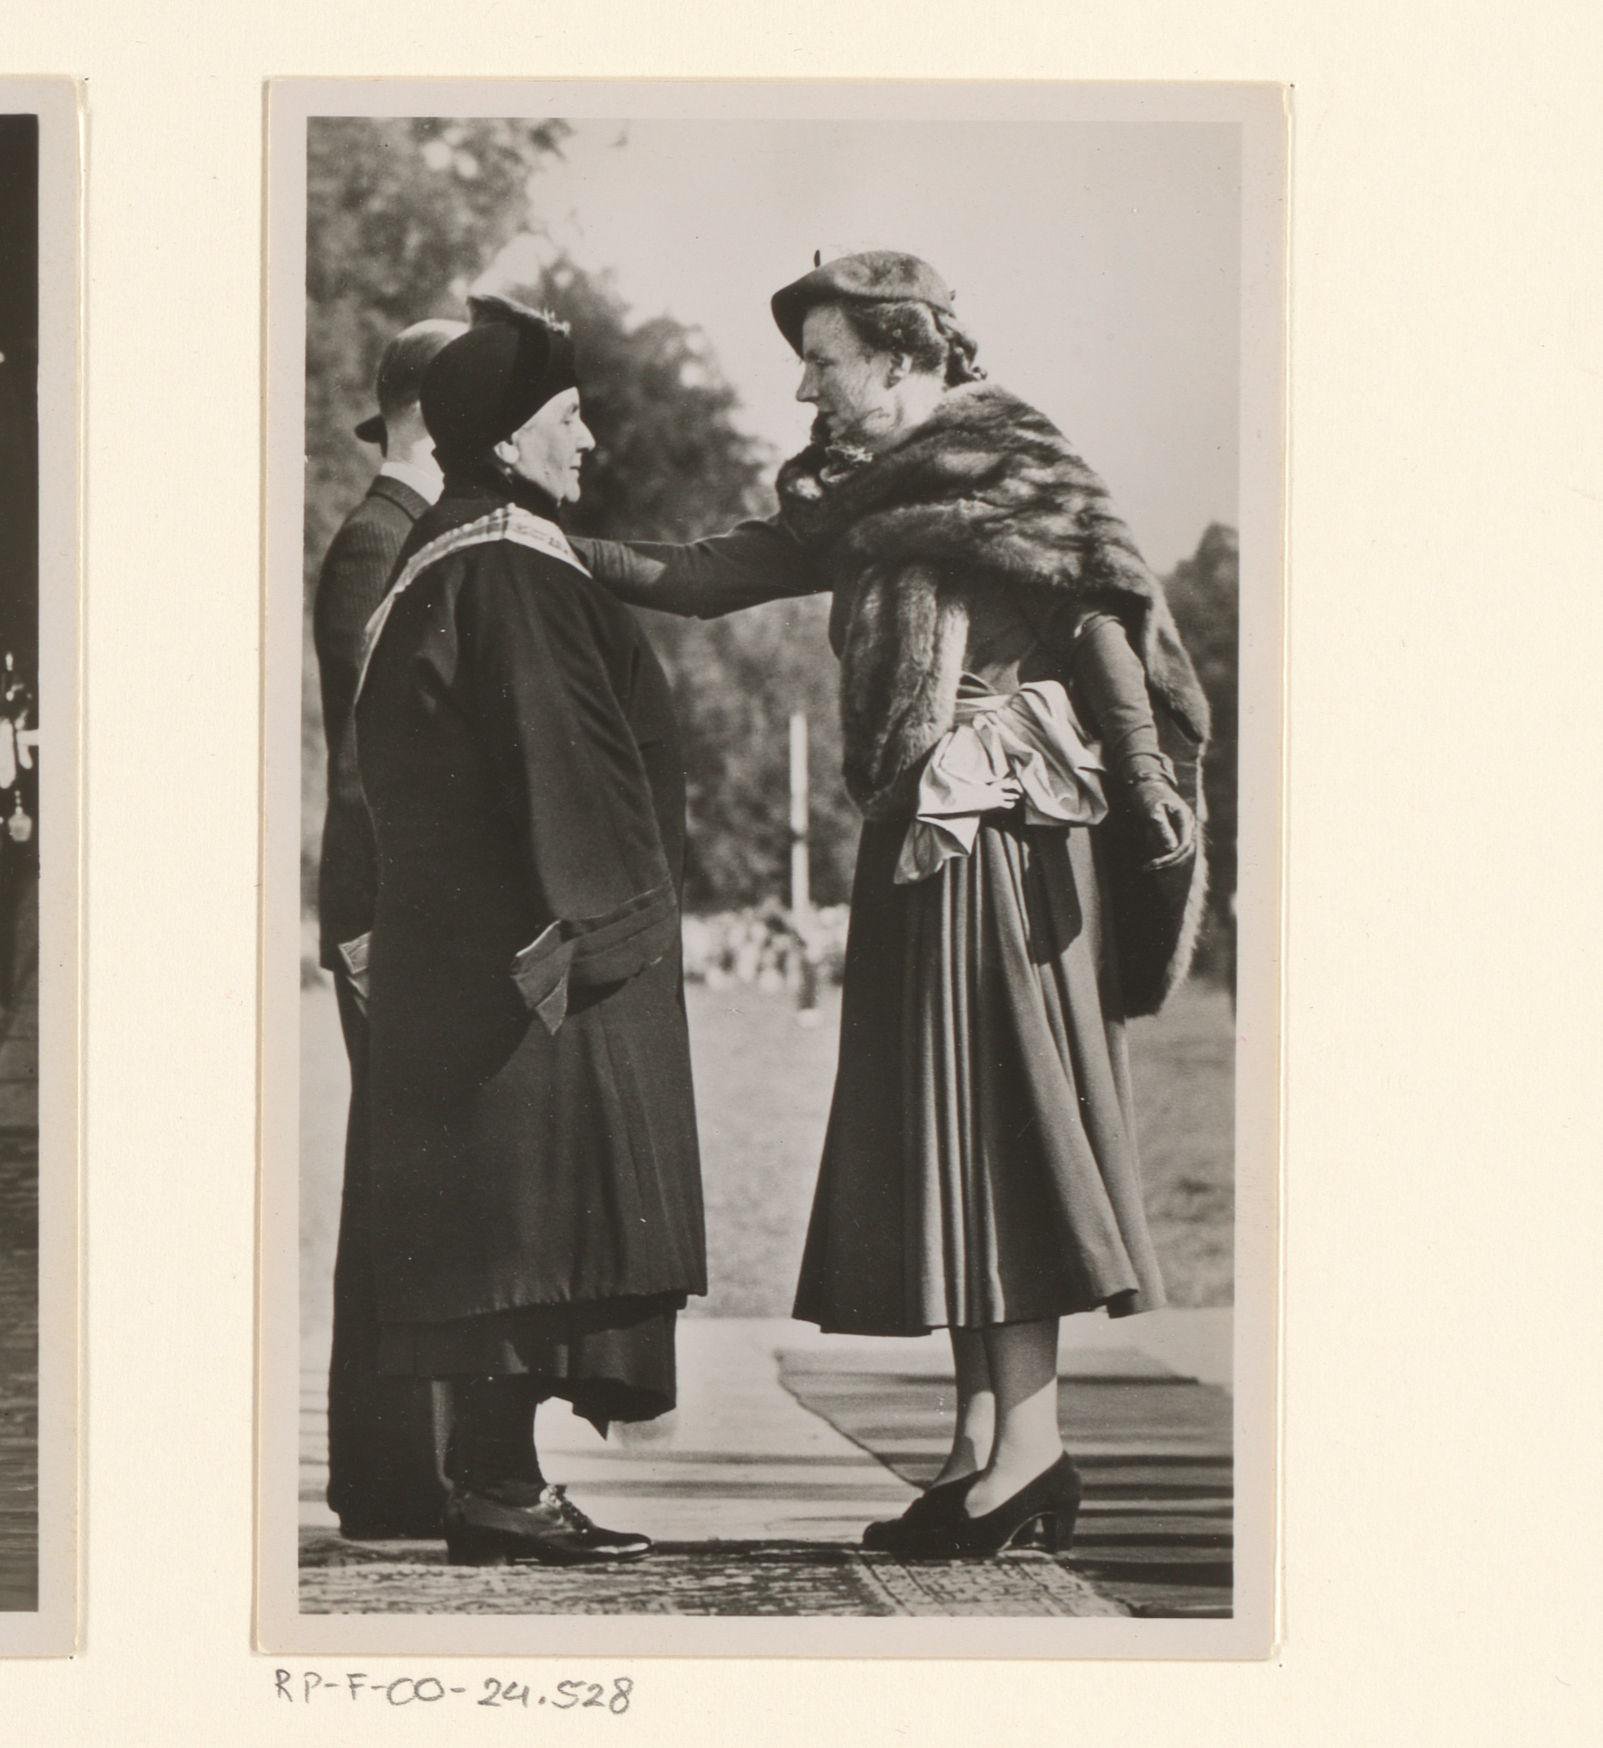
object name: ansichtkaart, prentbriefkaart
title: De "ridderslag" / Sonsbeek, Arnhem, 4 October 1948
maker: Anonymous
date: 1948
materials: paper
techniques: gelatin silver print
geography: amsterdam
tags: print maker, wilhelmina of the netherlands, the hague, juliana of the netherlands, historical persons - bb - woman, blow or slap with sword, accolade (~ knighting), dubbing a knight with full ceremony, arnhem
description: Prinses Wilhelmina ontvangt de Militaire Willemsorde van koningin Juliana, te Sonsbeek in Arnhem, op 4 oktober 1948. Het moment van de ridderslag wanneer de koningin met haar hand stevig op de schouder van de prinses slaat.